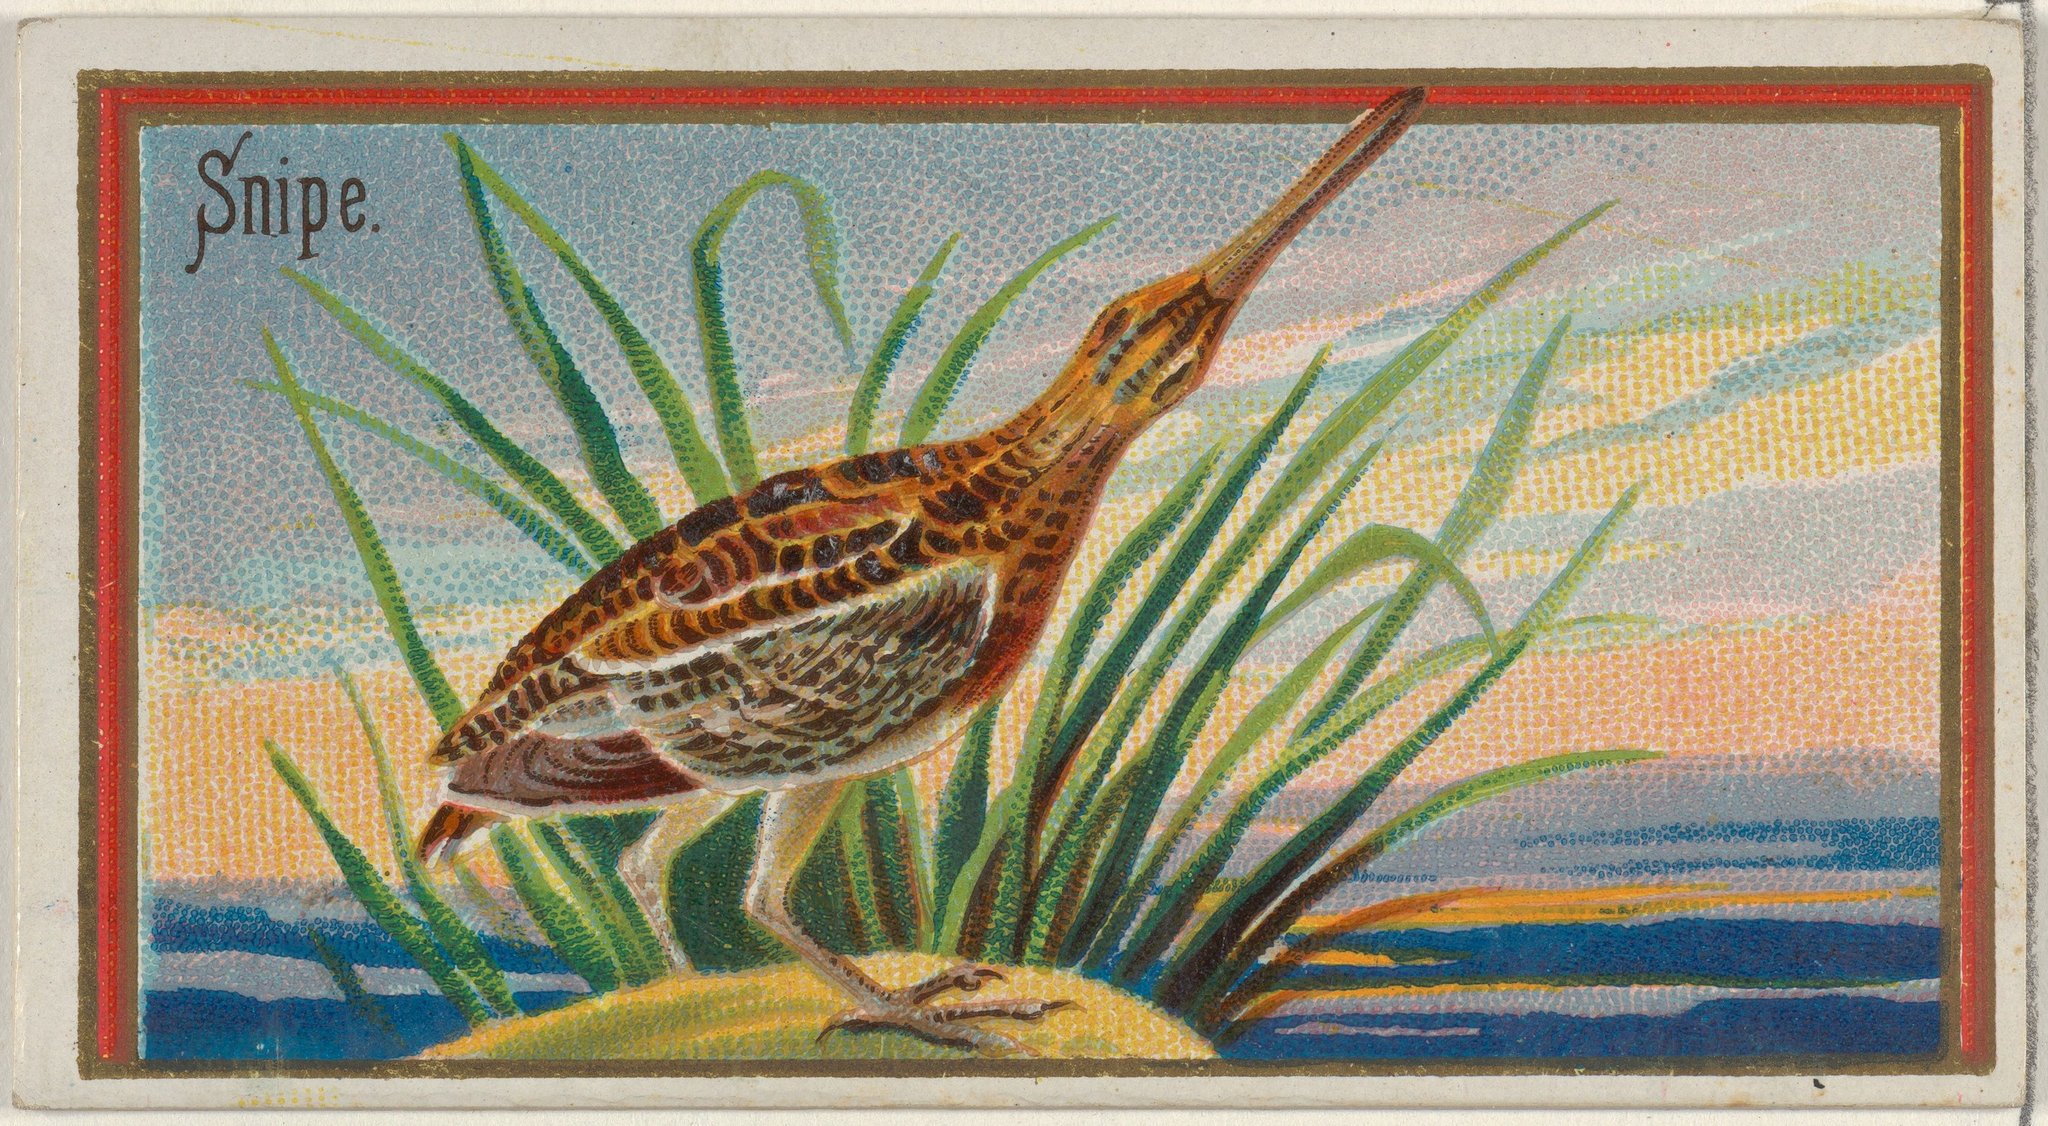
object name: print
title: Snipe, from the Game Birds series (N13) for Allen & Ginter Cigarettes Brands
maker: allen & ginter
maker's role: publisher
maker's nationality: american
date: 1889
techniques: color lithograph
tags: birds